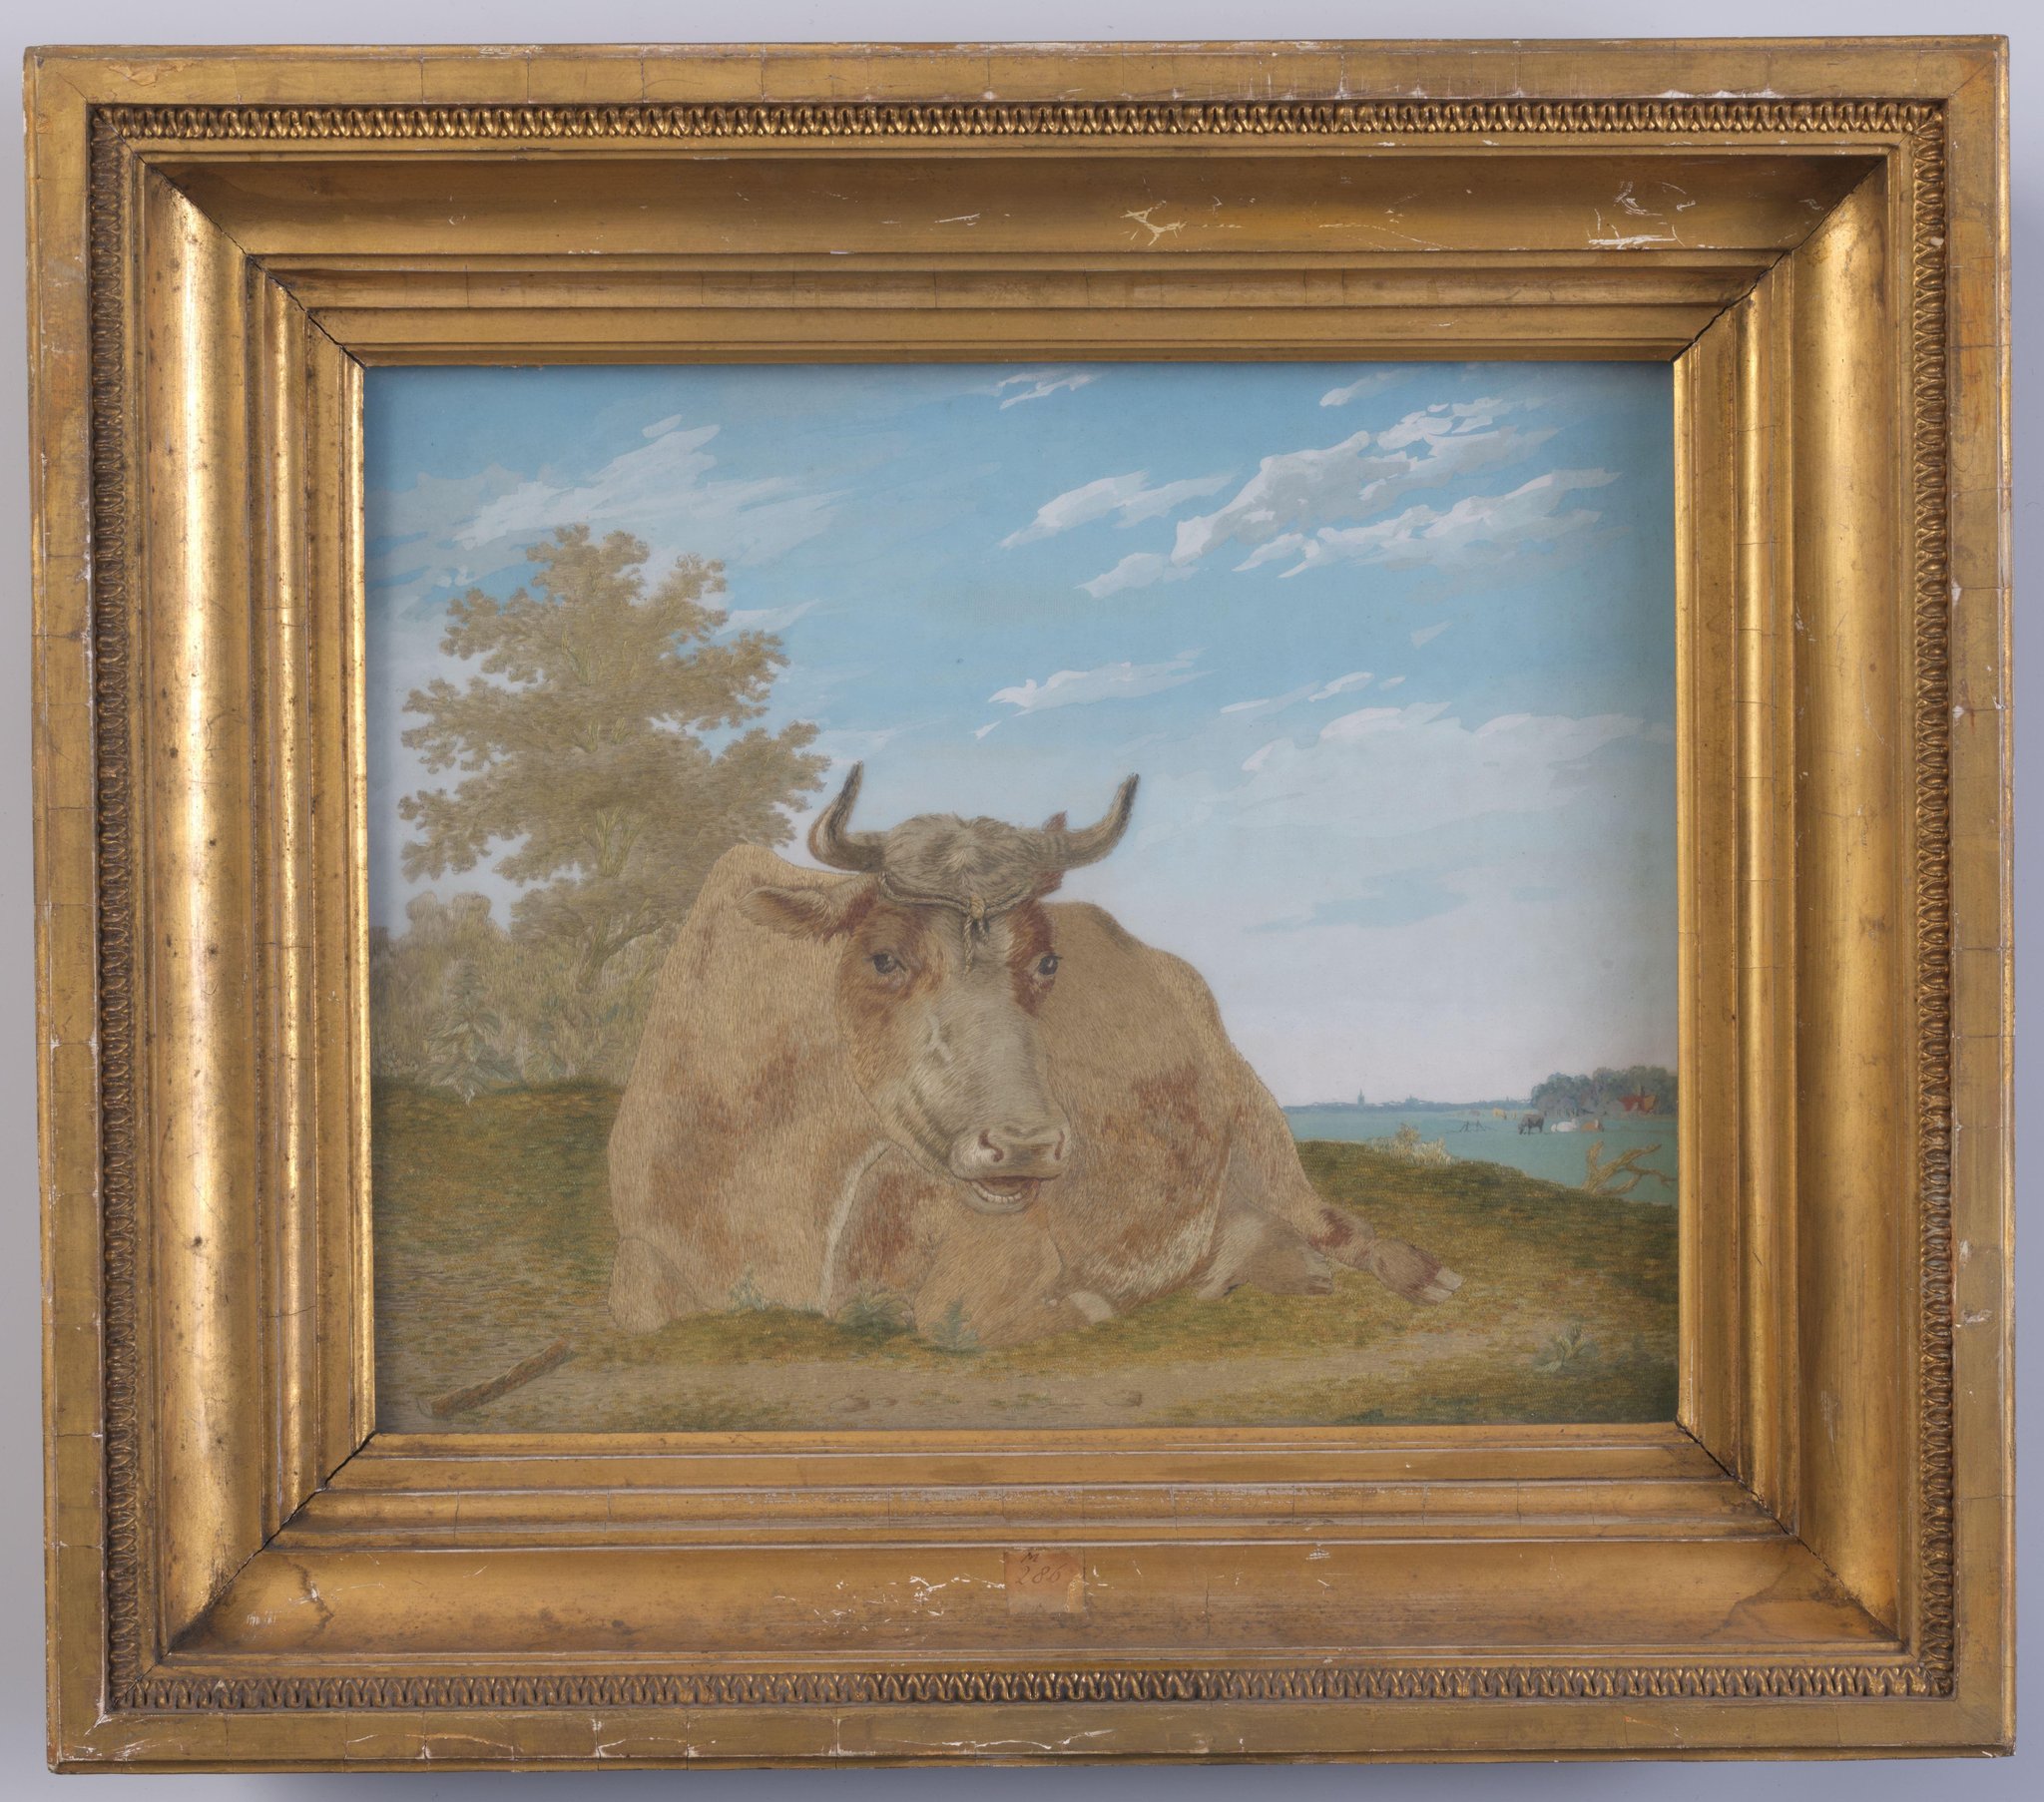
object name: tableau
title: Geborduurd tableau van Chenille en zijde.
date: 1800-1850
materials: textile, silk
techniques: embroidered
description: Geborduurd tableau van Chenille en zijde. De voorstelling betreft een landschap met op de voorgrond een liggende koe. Rechts op de achtergrond zijn huizen en koeien zichtbaar en links op de achtergrond een boom en struiken. Het tableau is ingelijst in een vergulde lijst.